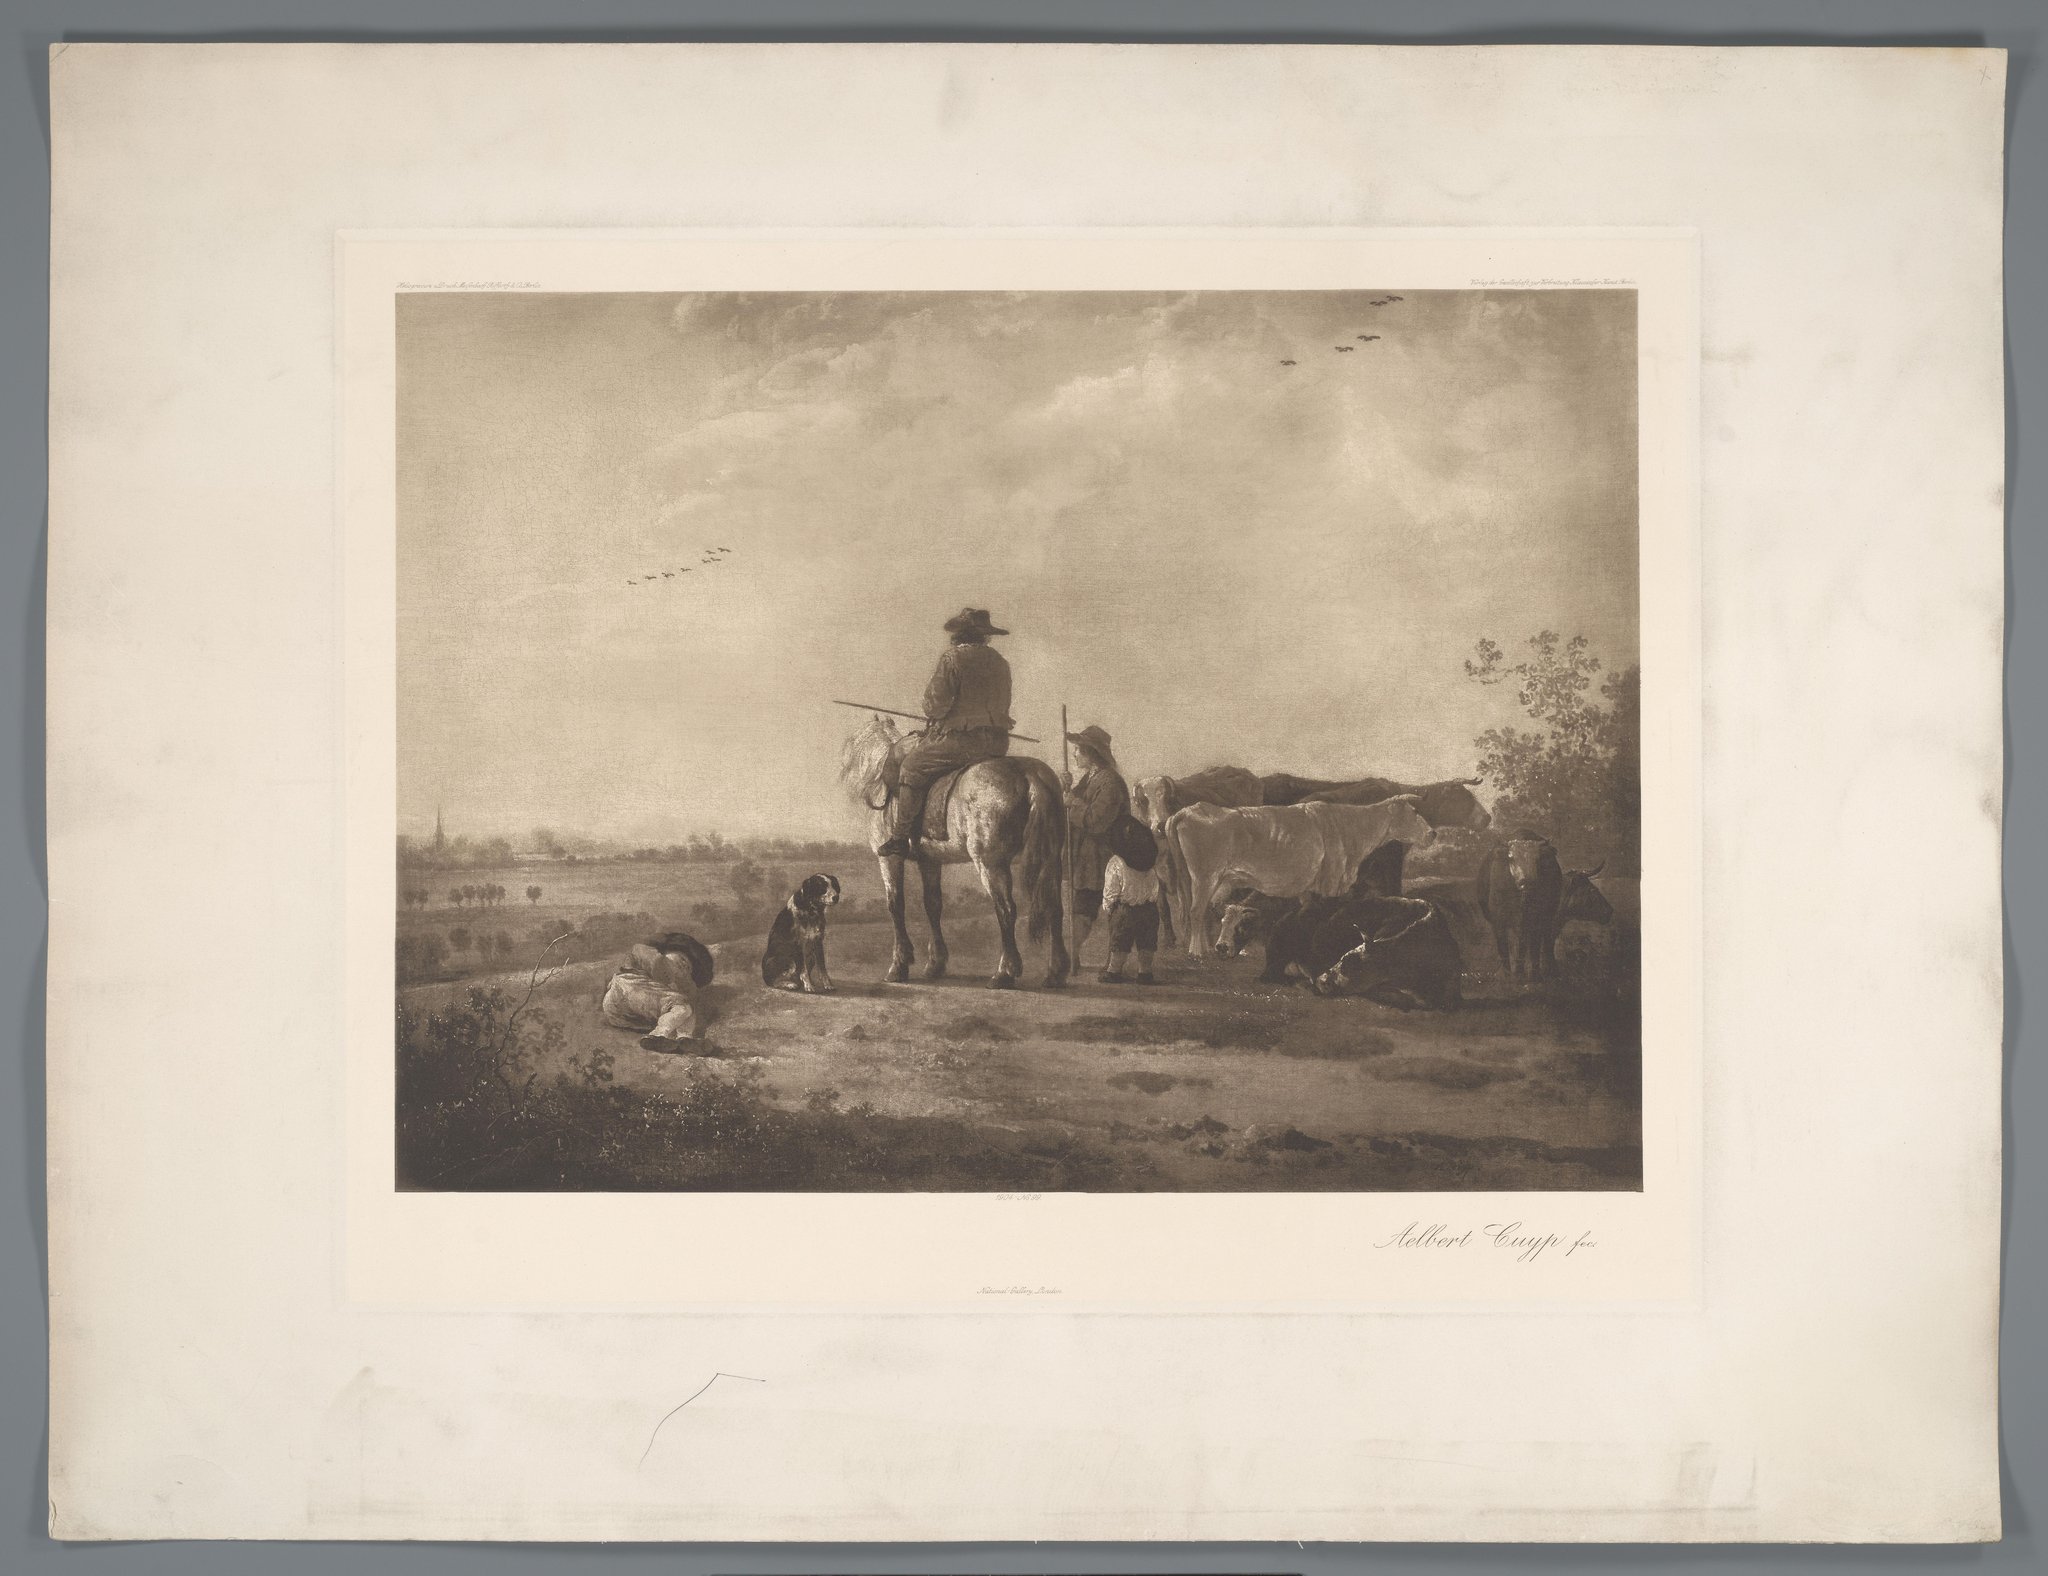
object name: reproduction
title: Fotoreproductie van Landschap met ruiter, herders en vee door Aelbert Cuyp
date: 1904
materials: cardboard, paper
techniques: photoaquatint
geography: berlin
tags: herding, herdsman, herdswoman, shepherd, shepherdess, cowherd, etc., cattle, picture, painting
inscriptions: inscription: ‘'04. 175’, inscription: ‘Heliogravure u. Druck Meisenbach Riffarth & Co, Berlin’, inscription: ‘1904 - No. 99./ National-Gallery. London’, inscription: ‘Verlag der Gesellschaft zur Verbreitung Klassischer Kunst. Berlin.’, inscription, gestempeld: ‘R: MVS.’, inscription: ‘Aelbert Cuyp fec.’